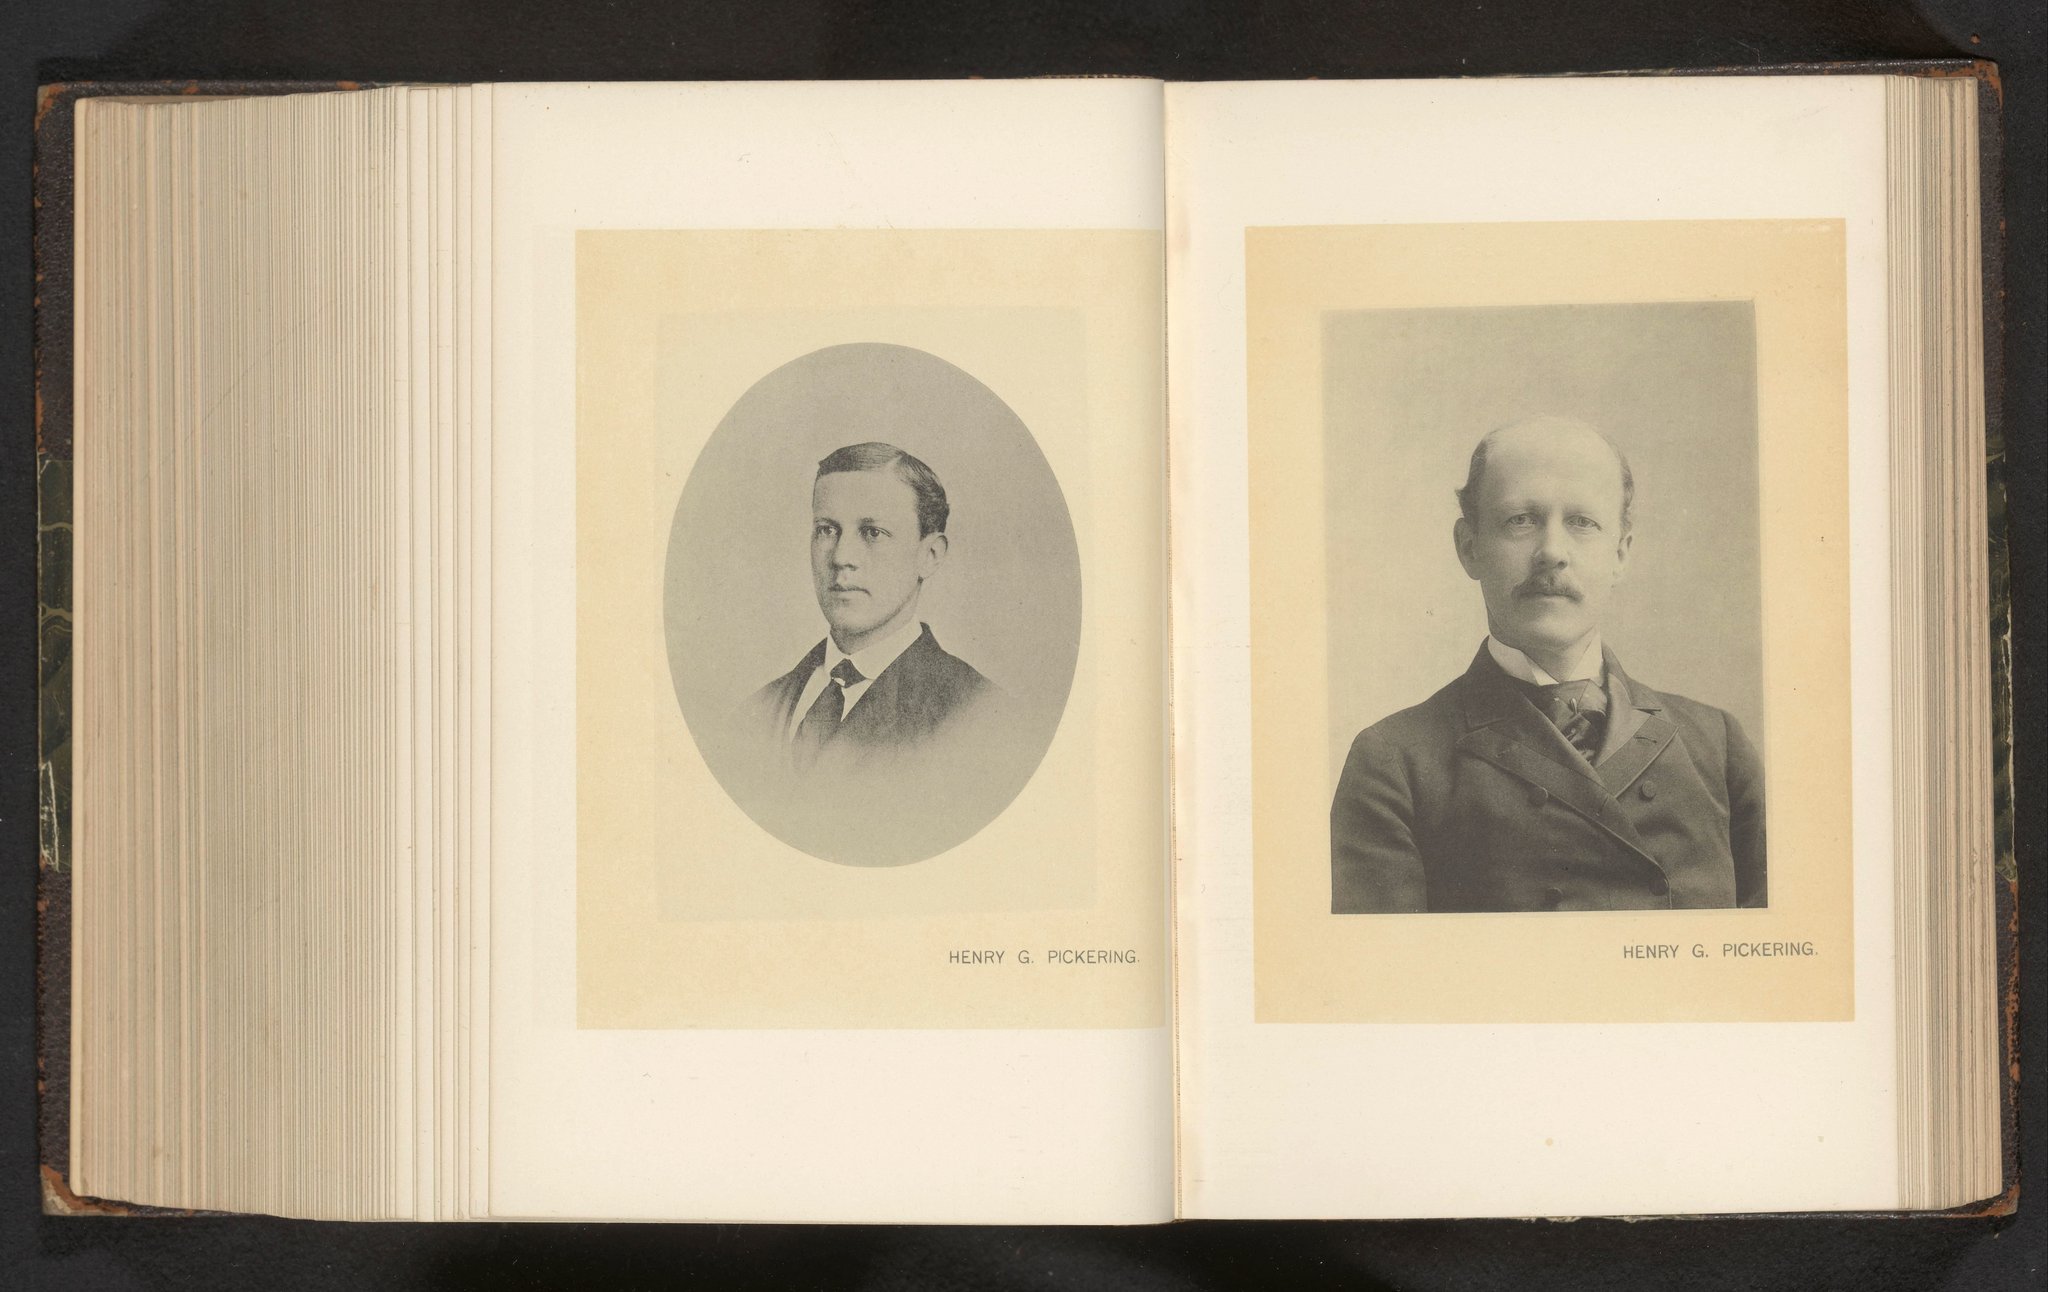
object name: photomechanical print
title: Henry G. Pickering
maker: Anonymous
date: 1889-1894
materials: paper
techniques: photoaquatint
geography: boston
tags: adult man